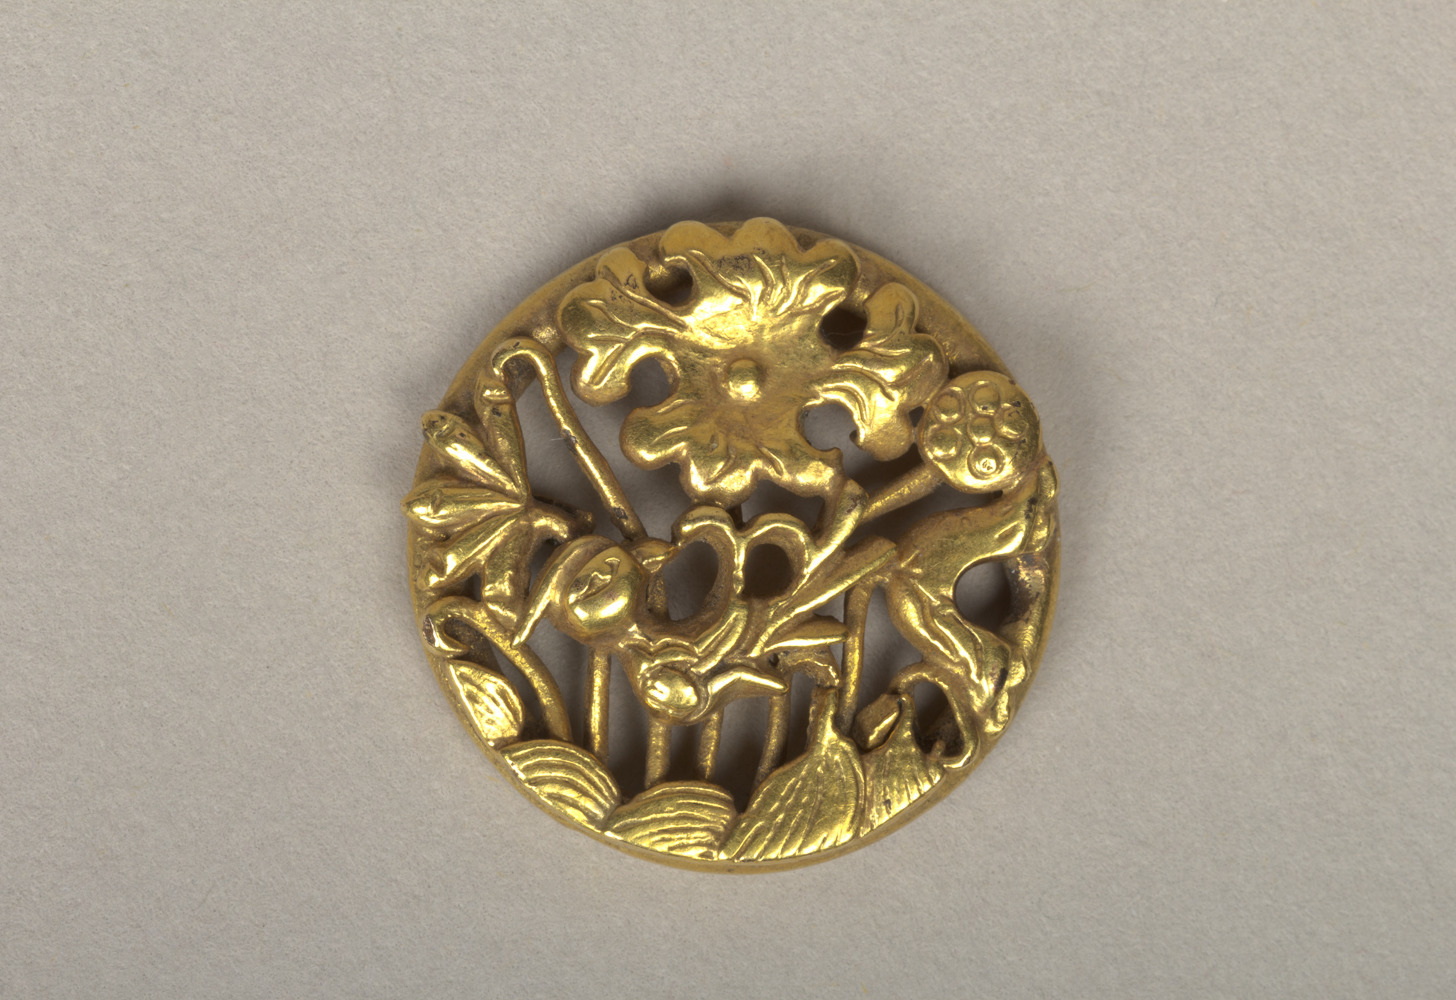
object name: ornament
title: Ornament with bird among lotuses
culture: korean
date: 918-1392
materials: gold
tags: birds